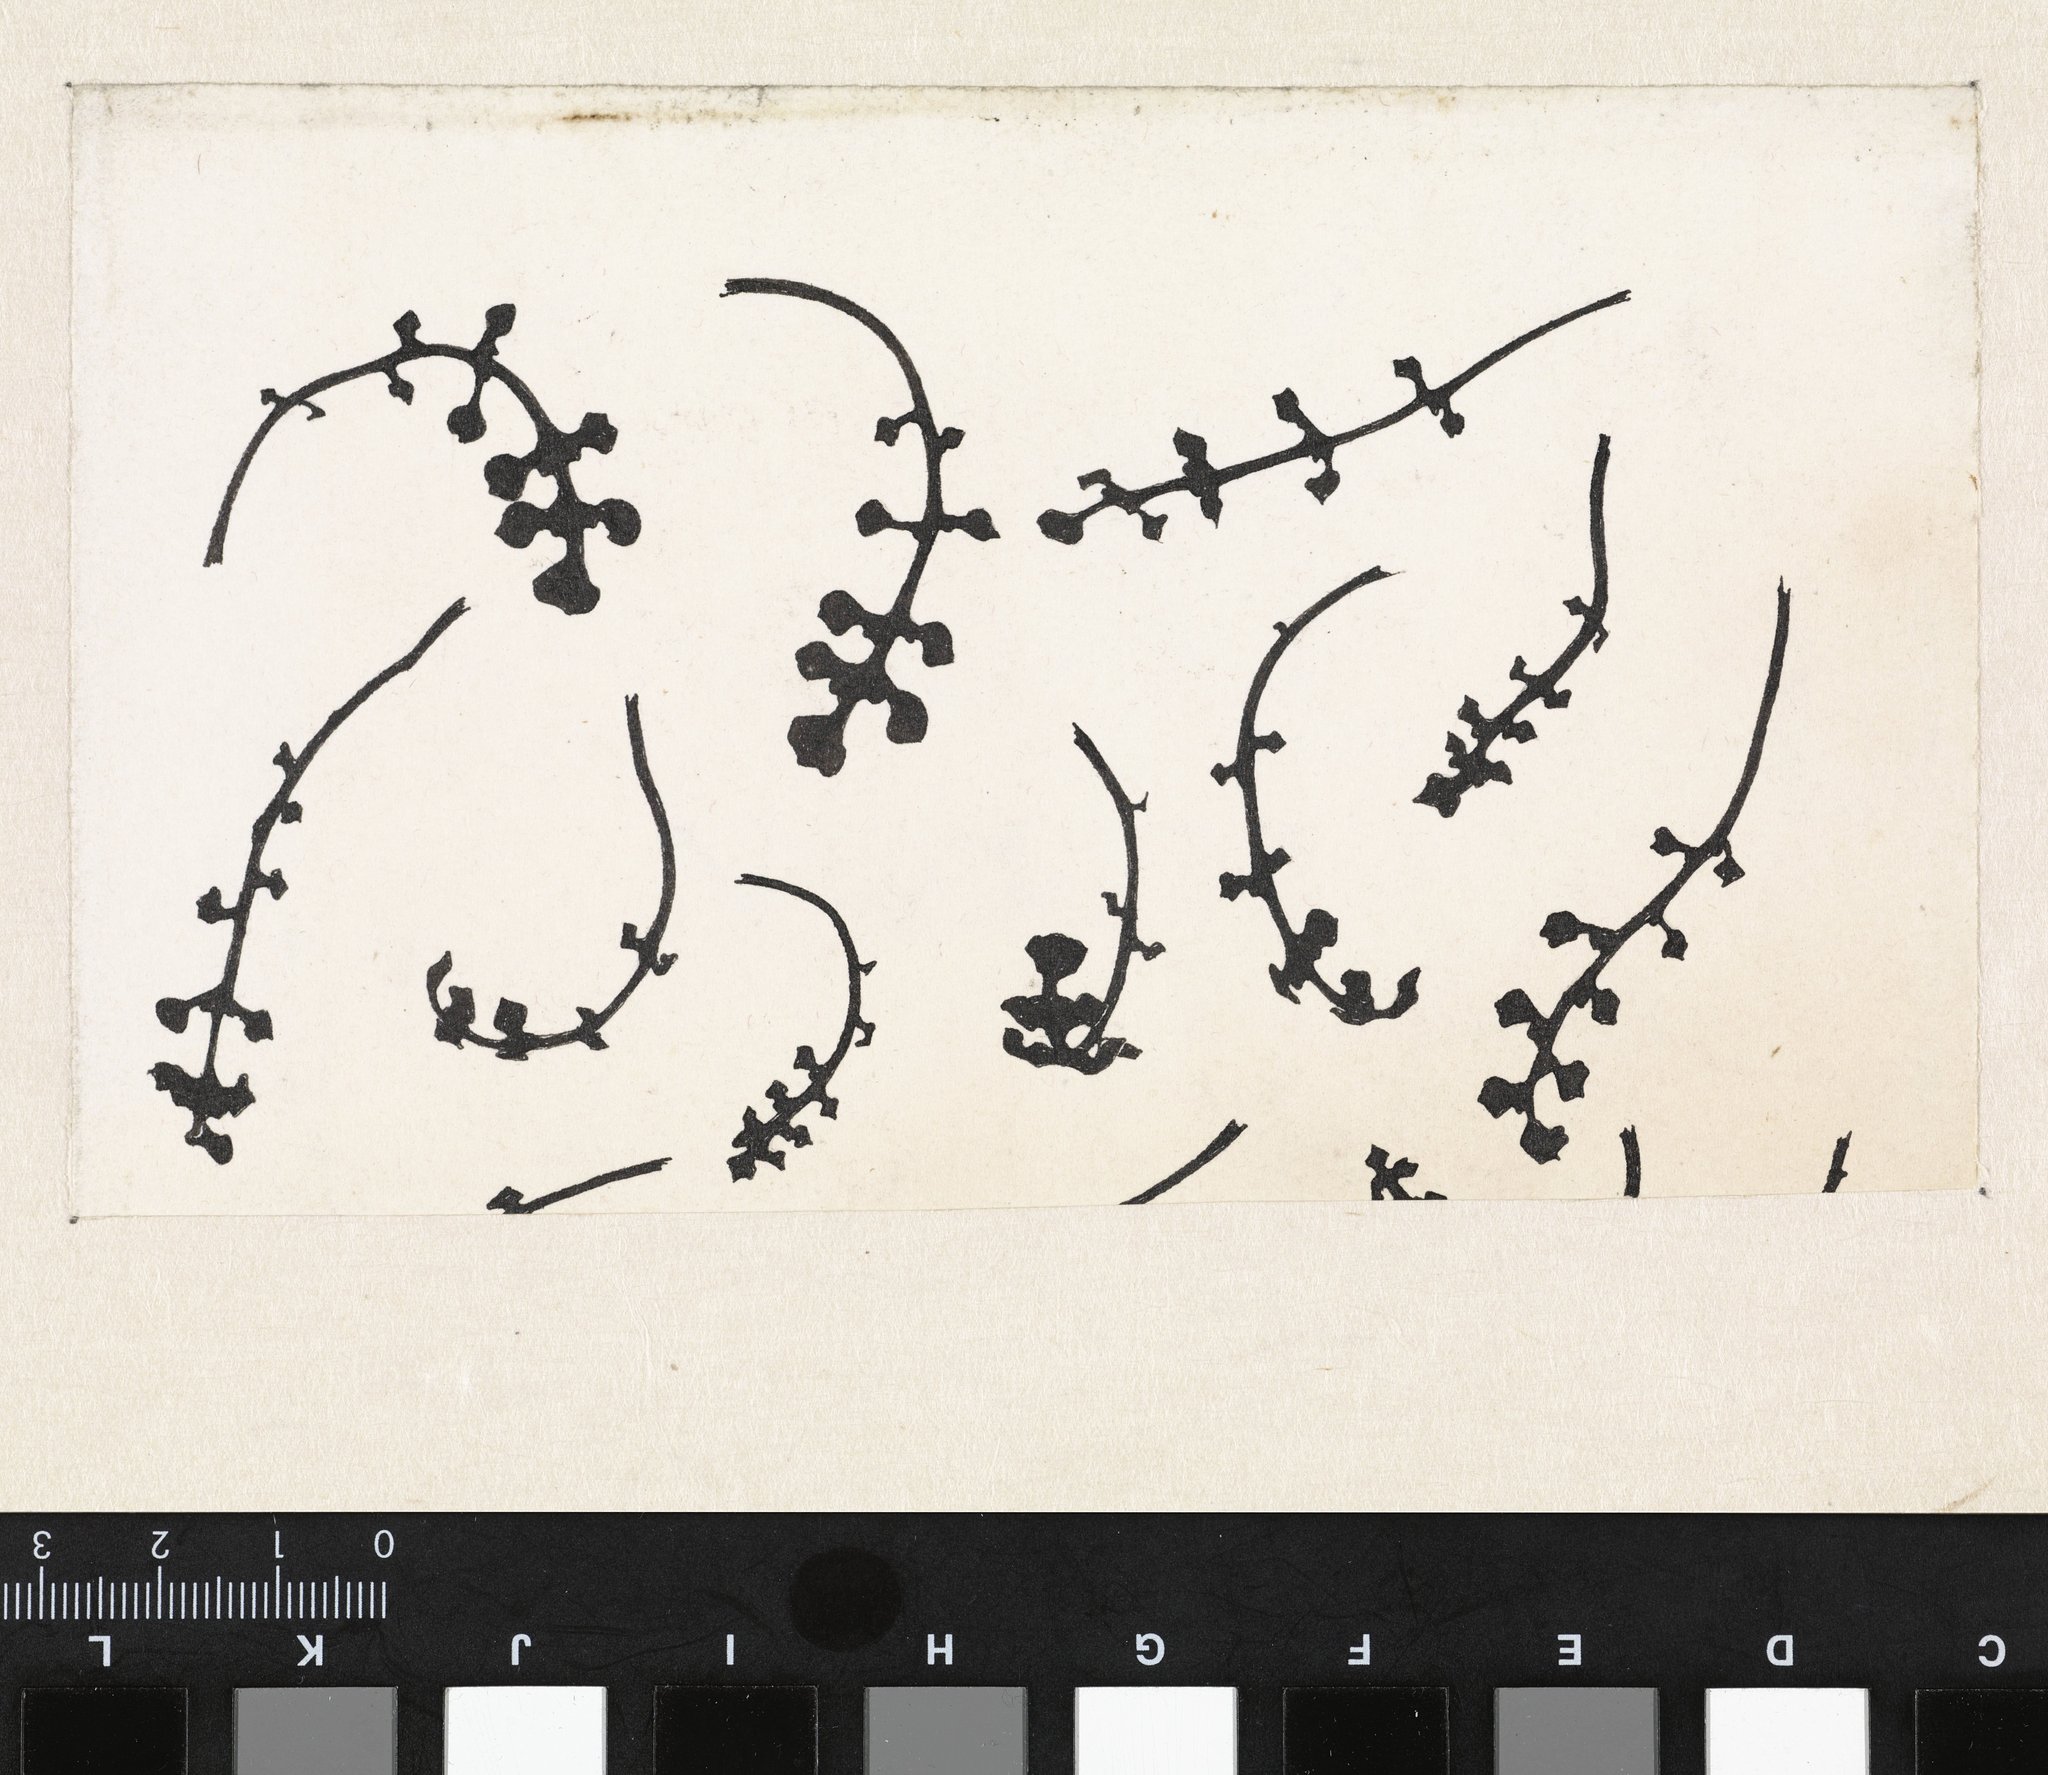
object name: drawing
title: Wortelrozetjes van de pinksterbloem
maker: julie de graag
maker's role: draughtsman, print maker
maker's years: 1877-1924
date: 1887-1924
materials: ink, paper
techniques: brush, pen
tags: plants and herbs: lady's-smock